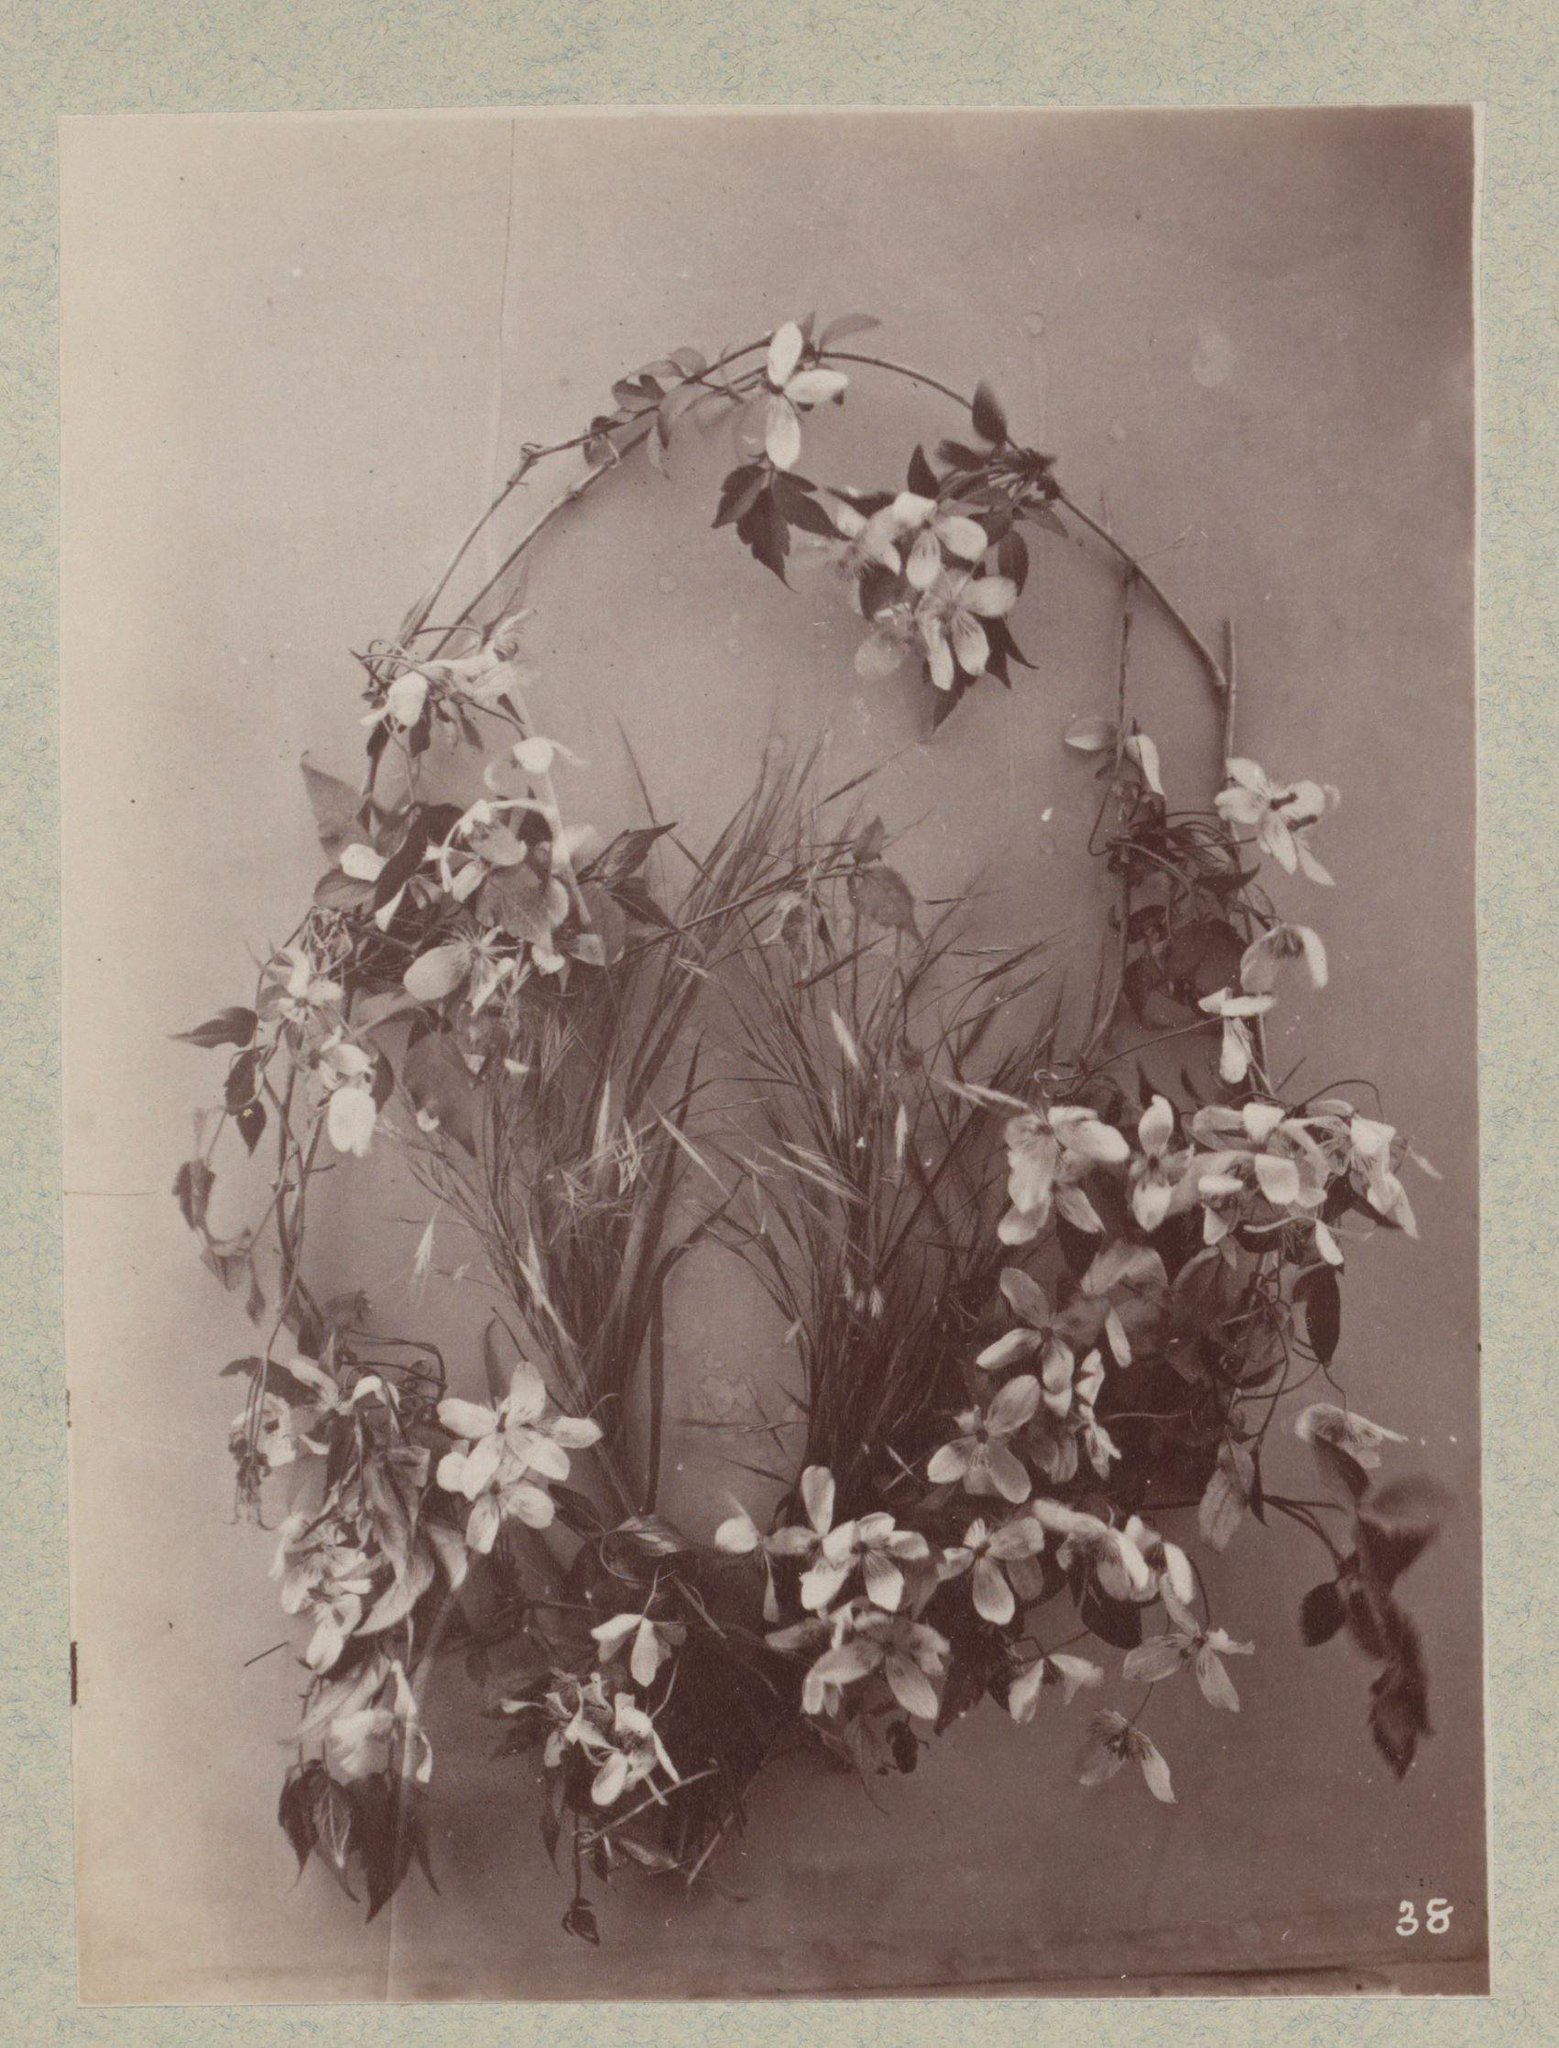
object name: photograph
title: Bloemstudie met twijgen en bladeren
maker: a. calavas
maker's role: publisher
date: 1875-1895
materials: cardboard, photographic support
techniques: albumen print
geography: paris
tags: flowers, plants; vegetation (+ branch, stick), plants; vegetation (+ leaf)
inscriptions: collector's mark: Lugt 3937, number: ‘38’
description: Onderdeel van Verzamelband met foto's van bloemstudies.